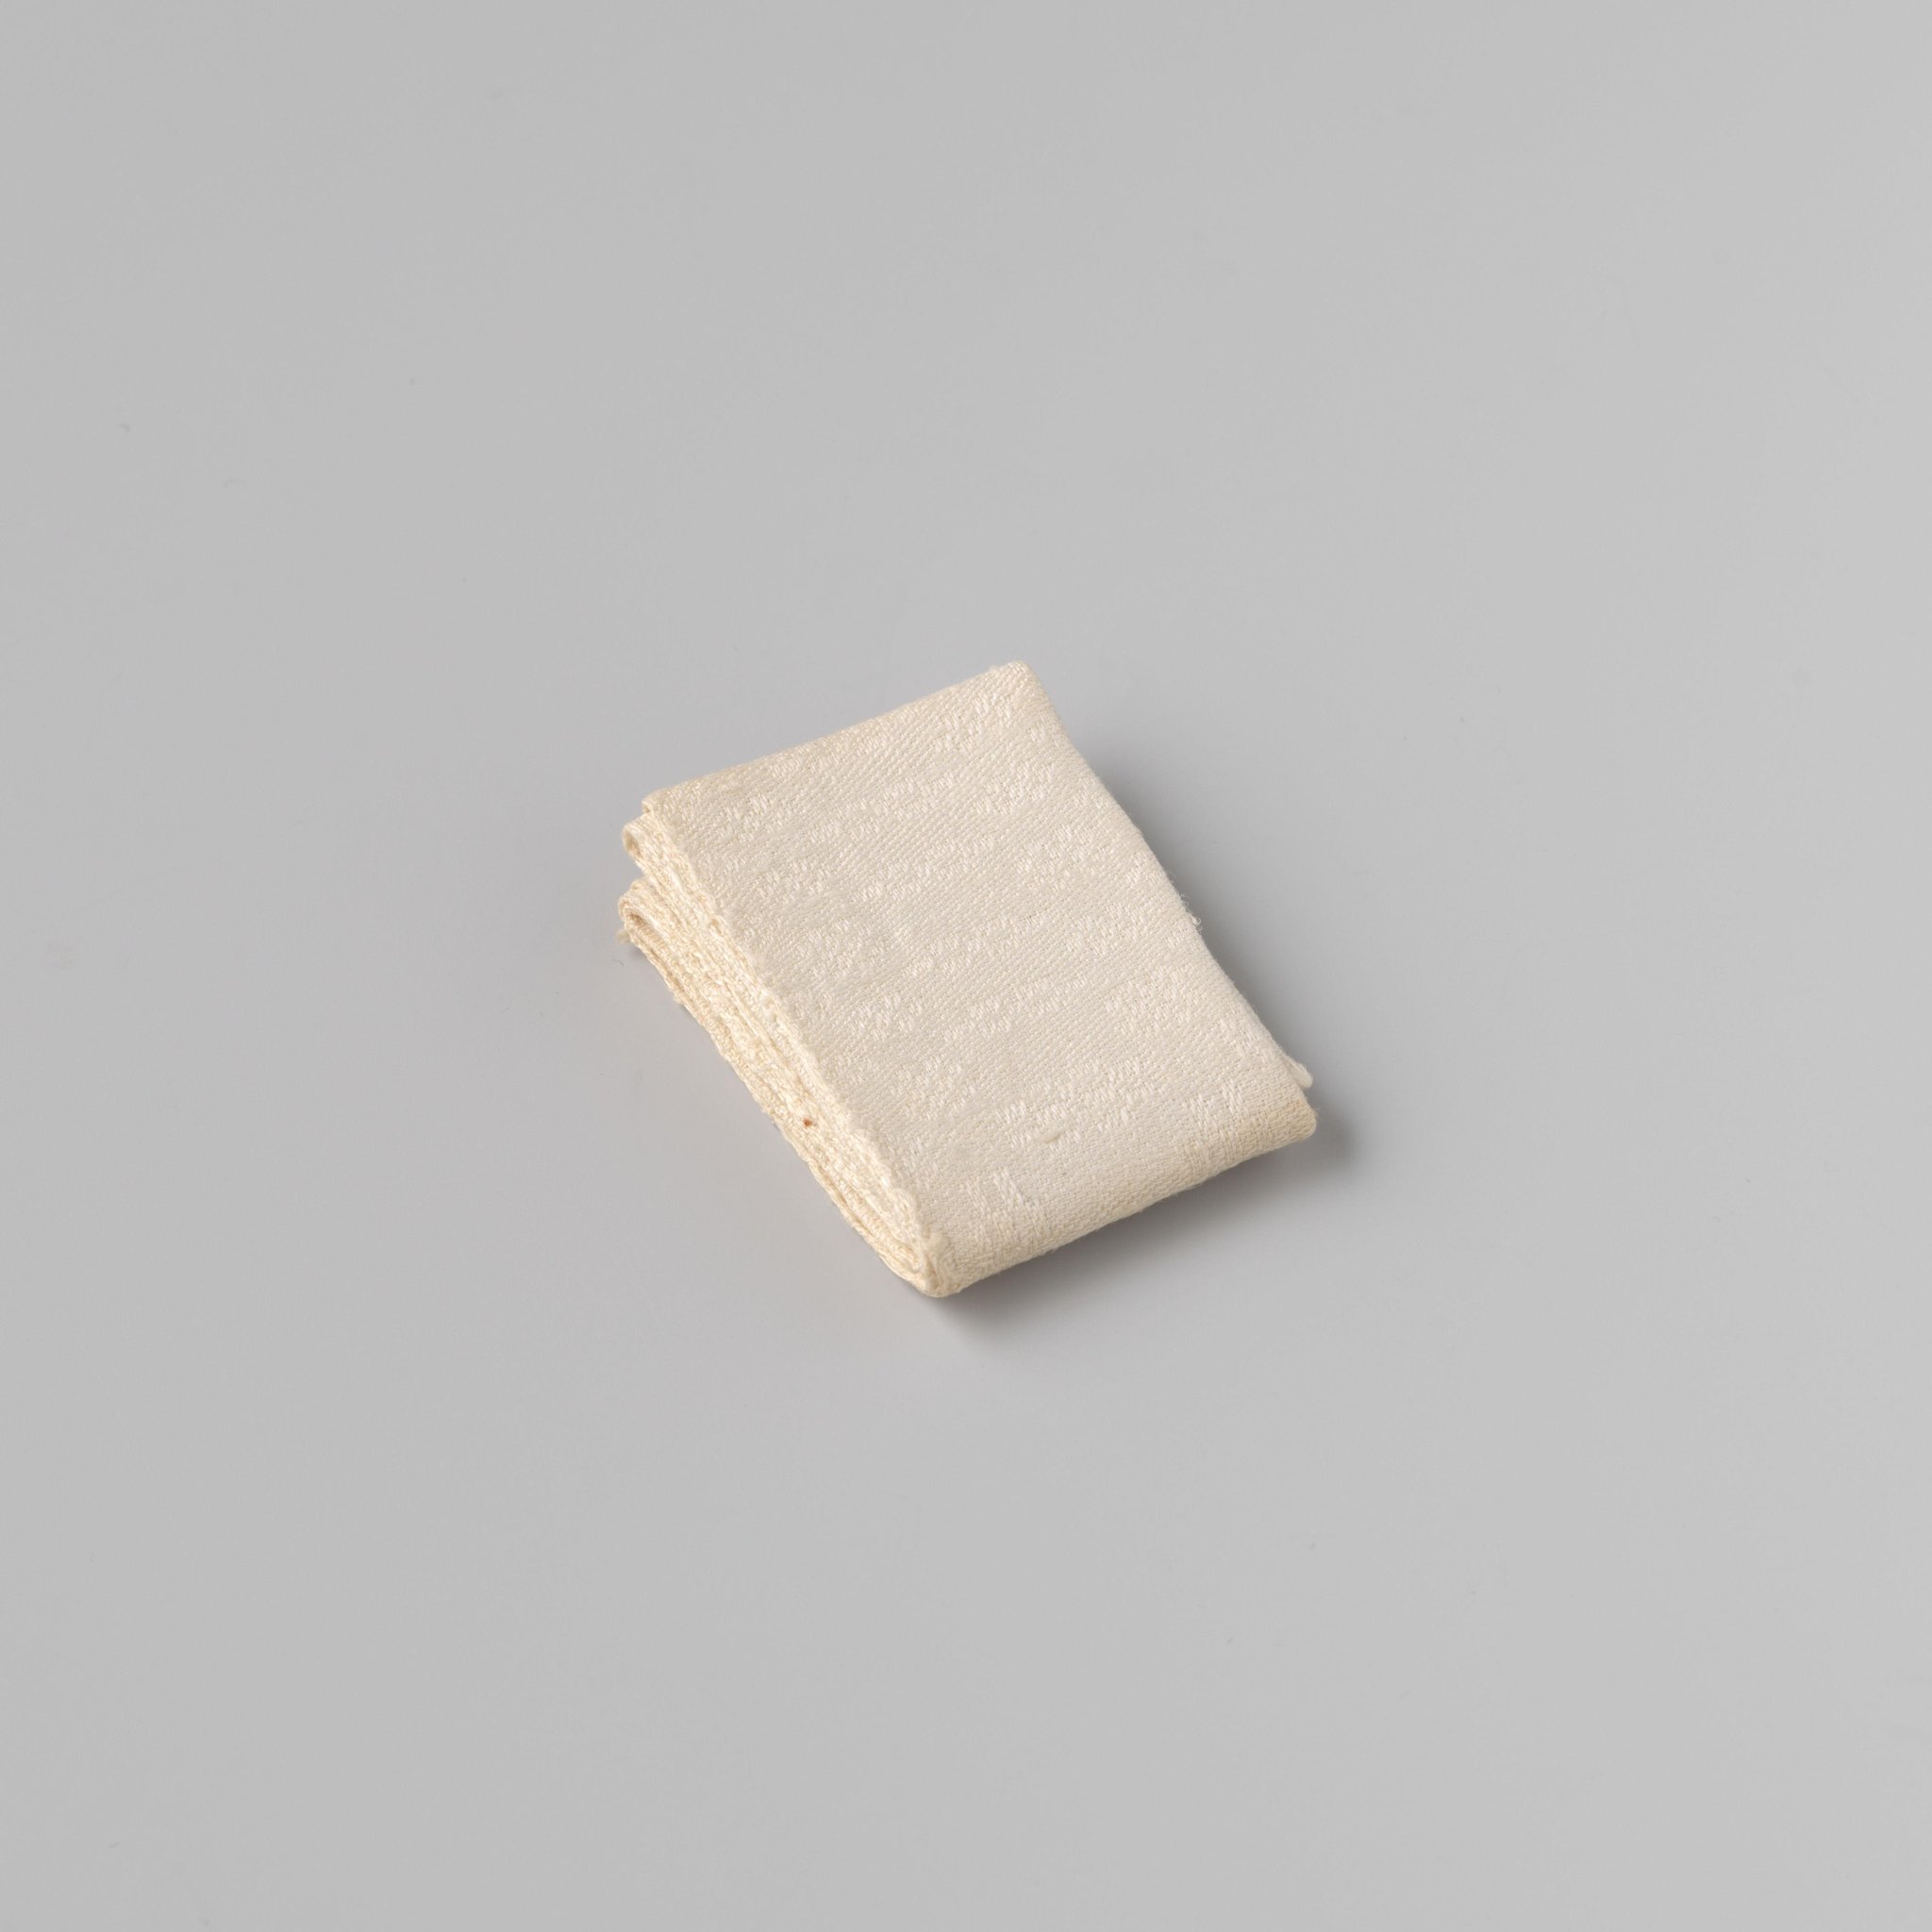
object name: miniature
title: Linnen servet van damastweefsel met pellenpatroon (motief III), geen zomen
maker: Anonymous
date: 1690-1710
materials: linen